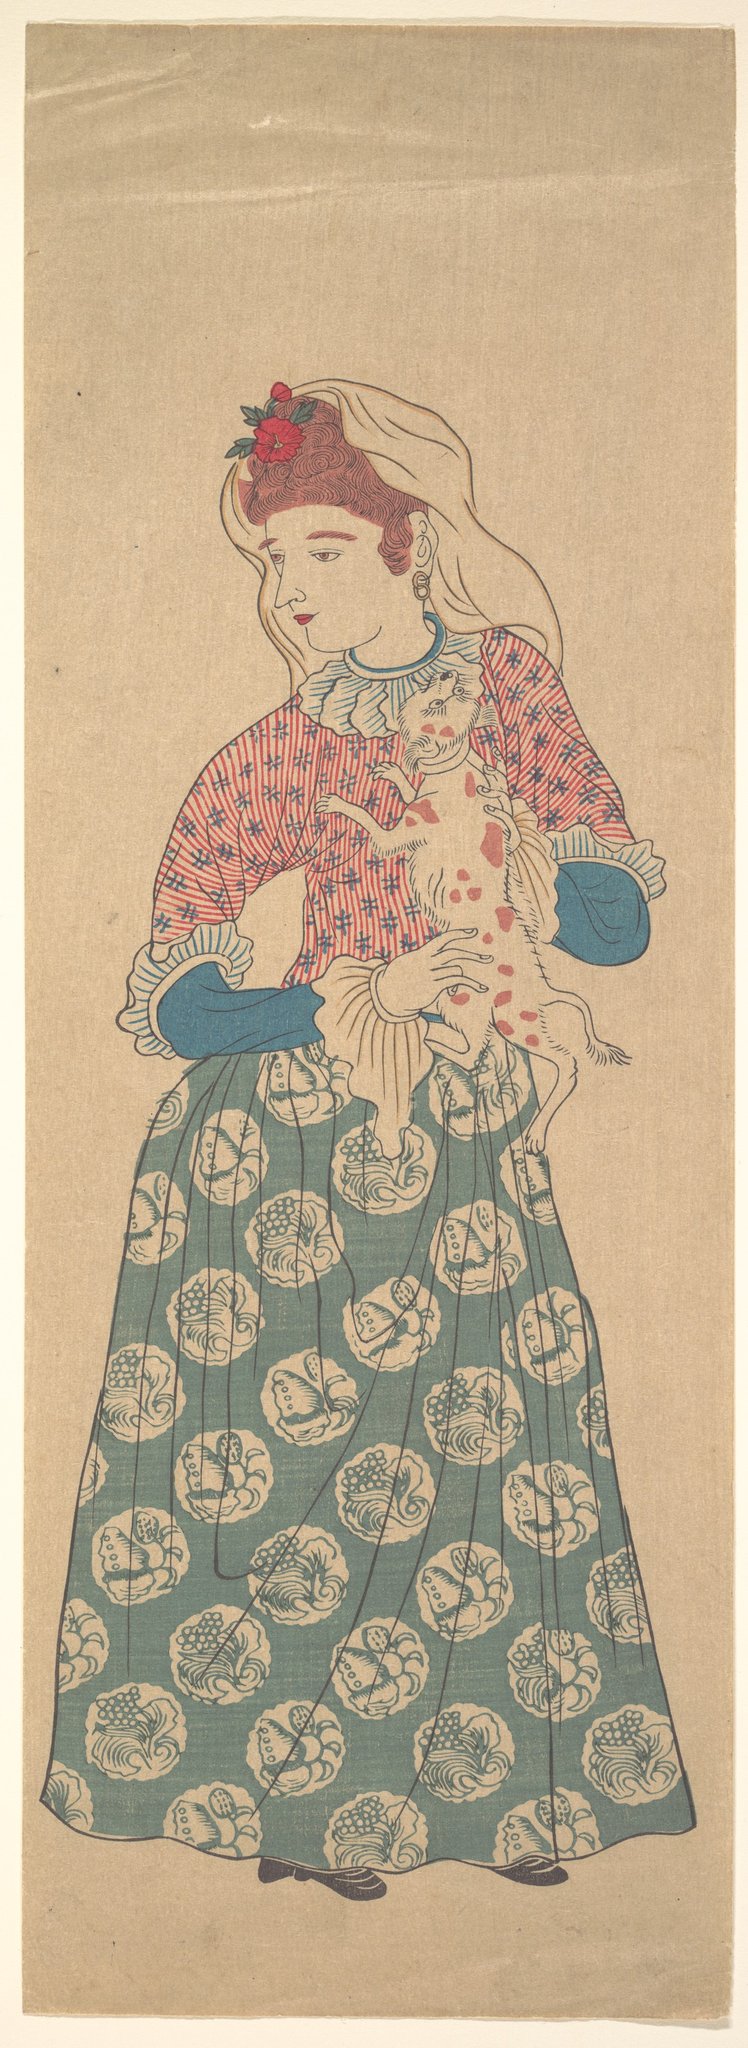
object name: woodblock print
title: Dutch Woman Holding a Dog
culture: japanese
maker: unidentified artist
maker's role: artist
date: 1801-1850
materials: ink, paper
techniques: woodblock print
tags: women,dogs